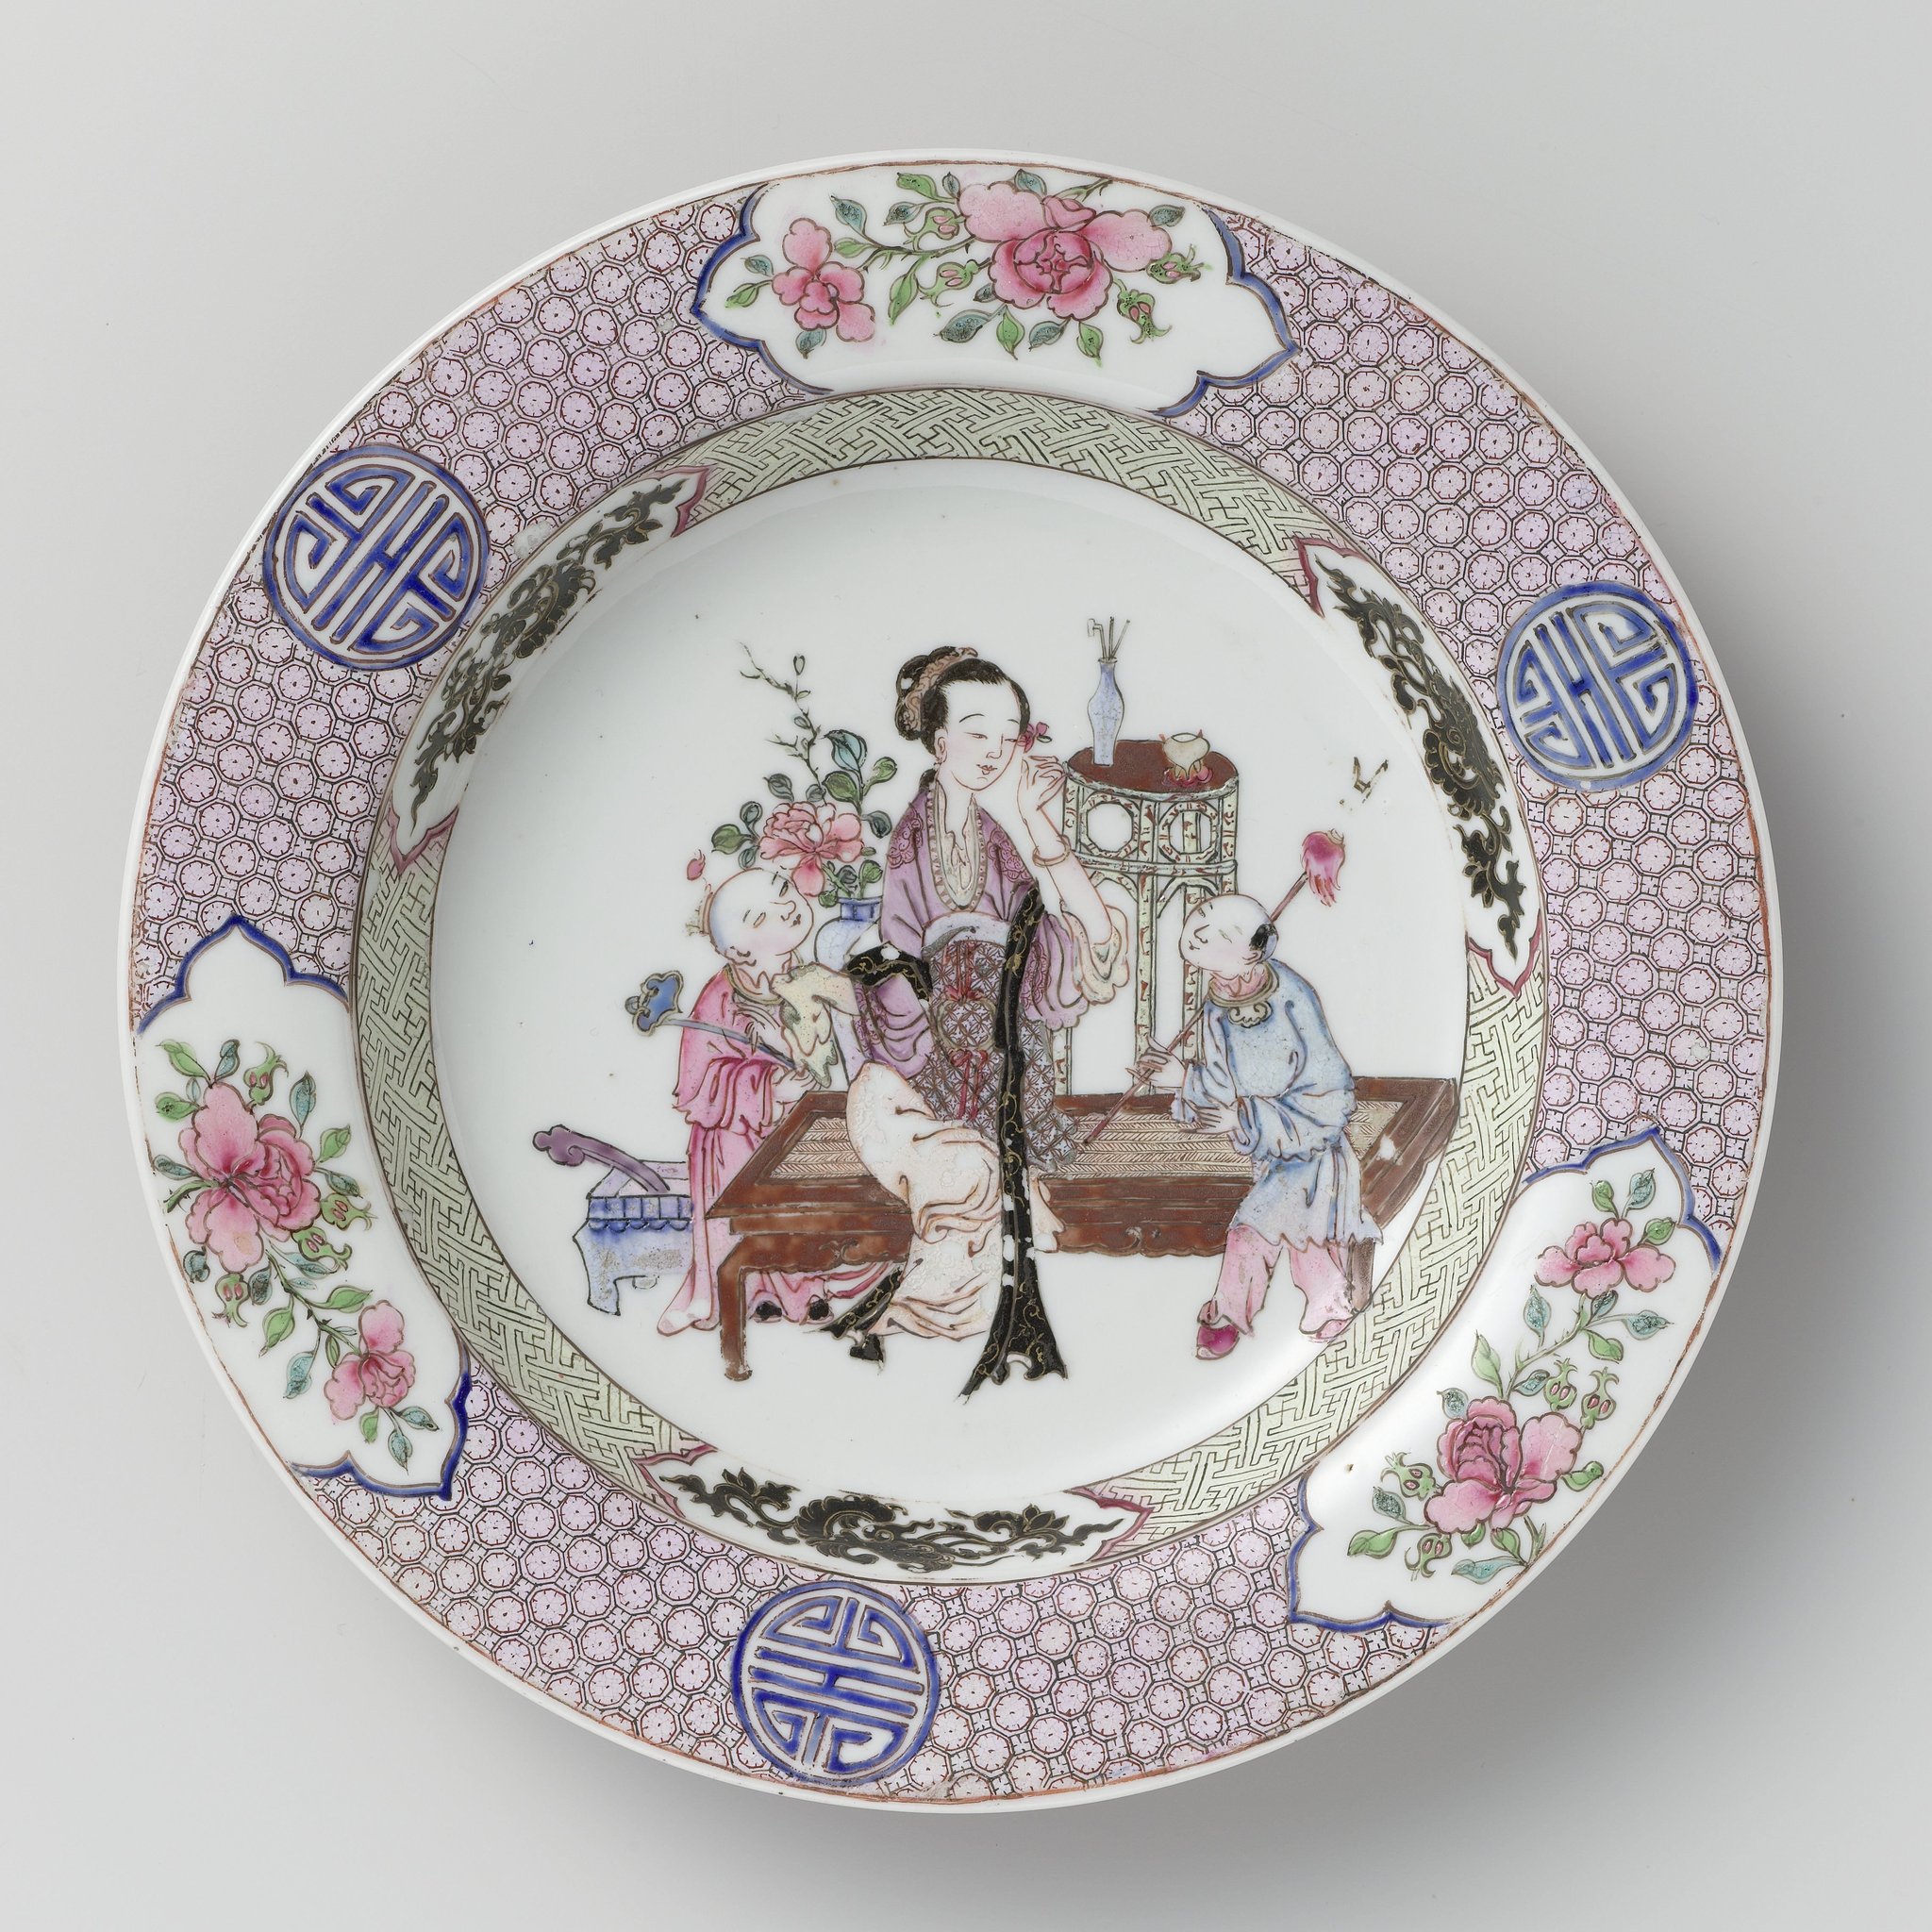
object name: plate dish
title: Deep plate with a woman and two boys among precious objects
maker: Anonymous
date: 1725-1749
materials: glaze, gold, paint, porcelain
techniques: firing, gilding, turning, vitrification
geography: china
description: Bord van porselein, half eierschaal. In 'famille-rose', 'ruby-back'. In het plat een een zittende Chinese dame met twee kinderen. Achter haar een tafeltje met wierookbrander een een vaas.